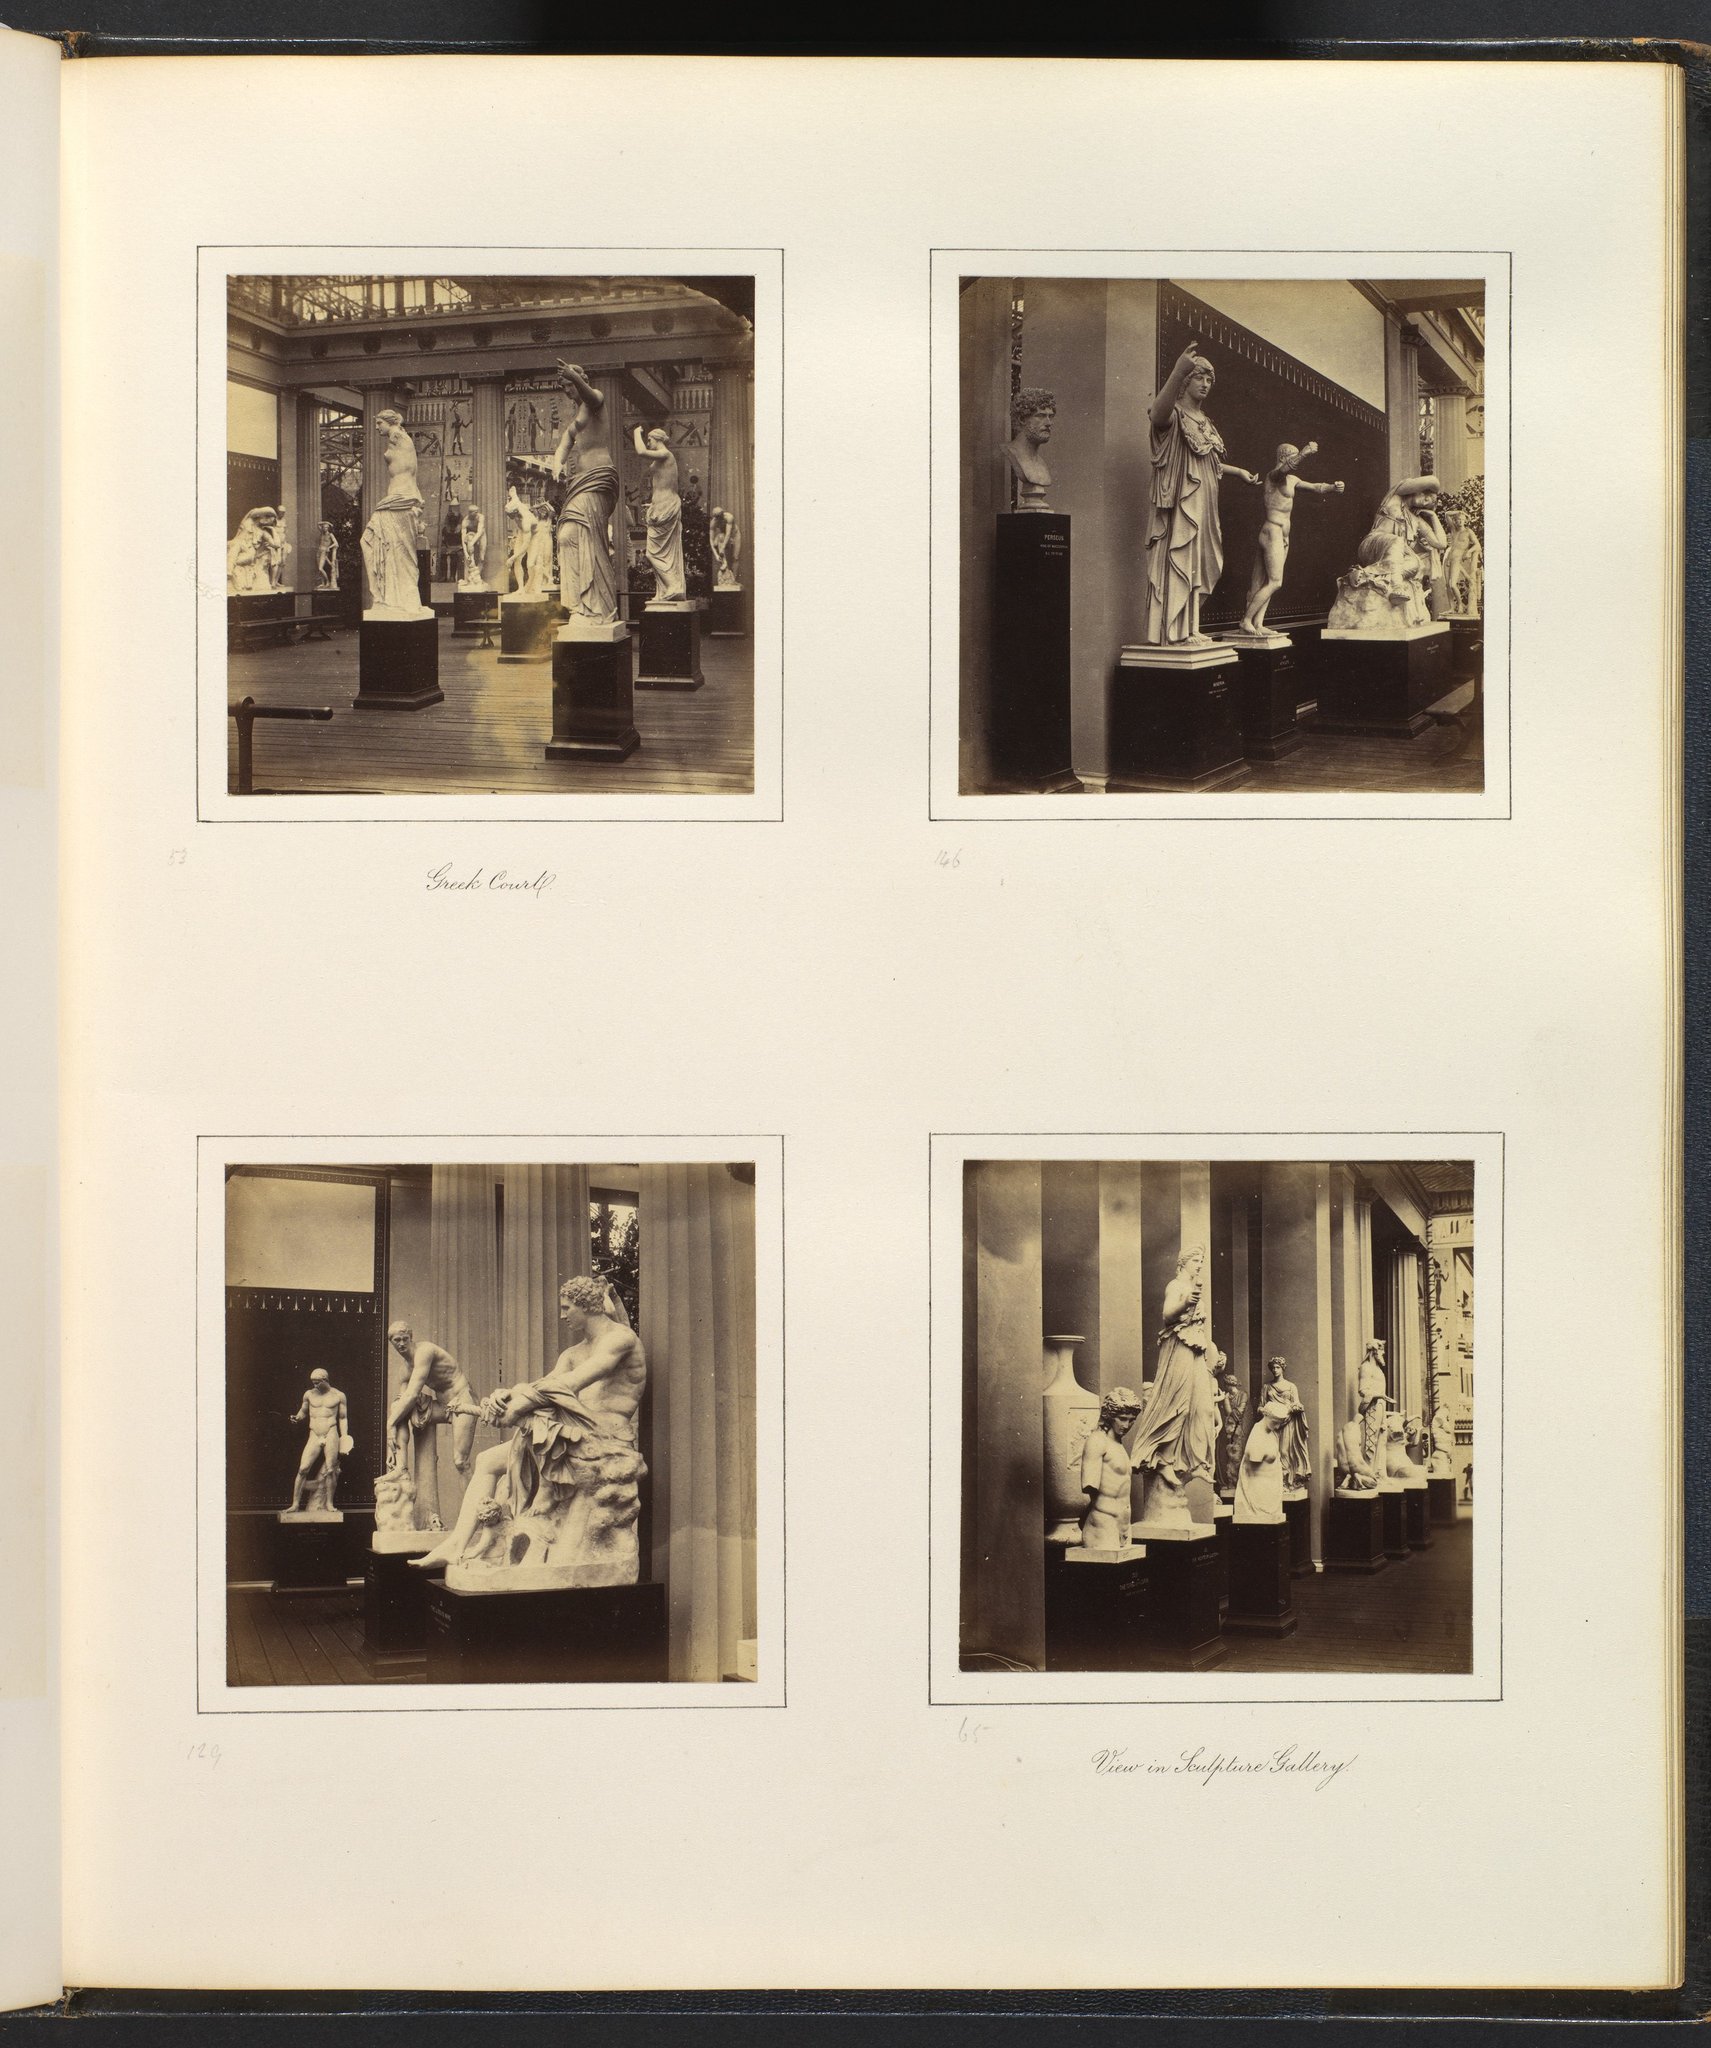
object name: photograph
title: [Greek Court; Statue of Minerva; Ludovisi Mars; Iris, Hecate, or Lucifera]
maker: philip henry delamotte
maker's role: artist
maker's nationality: british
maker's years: 1821-1889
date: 1859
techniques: albumen silver print, glass negative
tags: sculpture